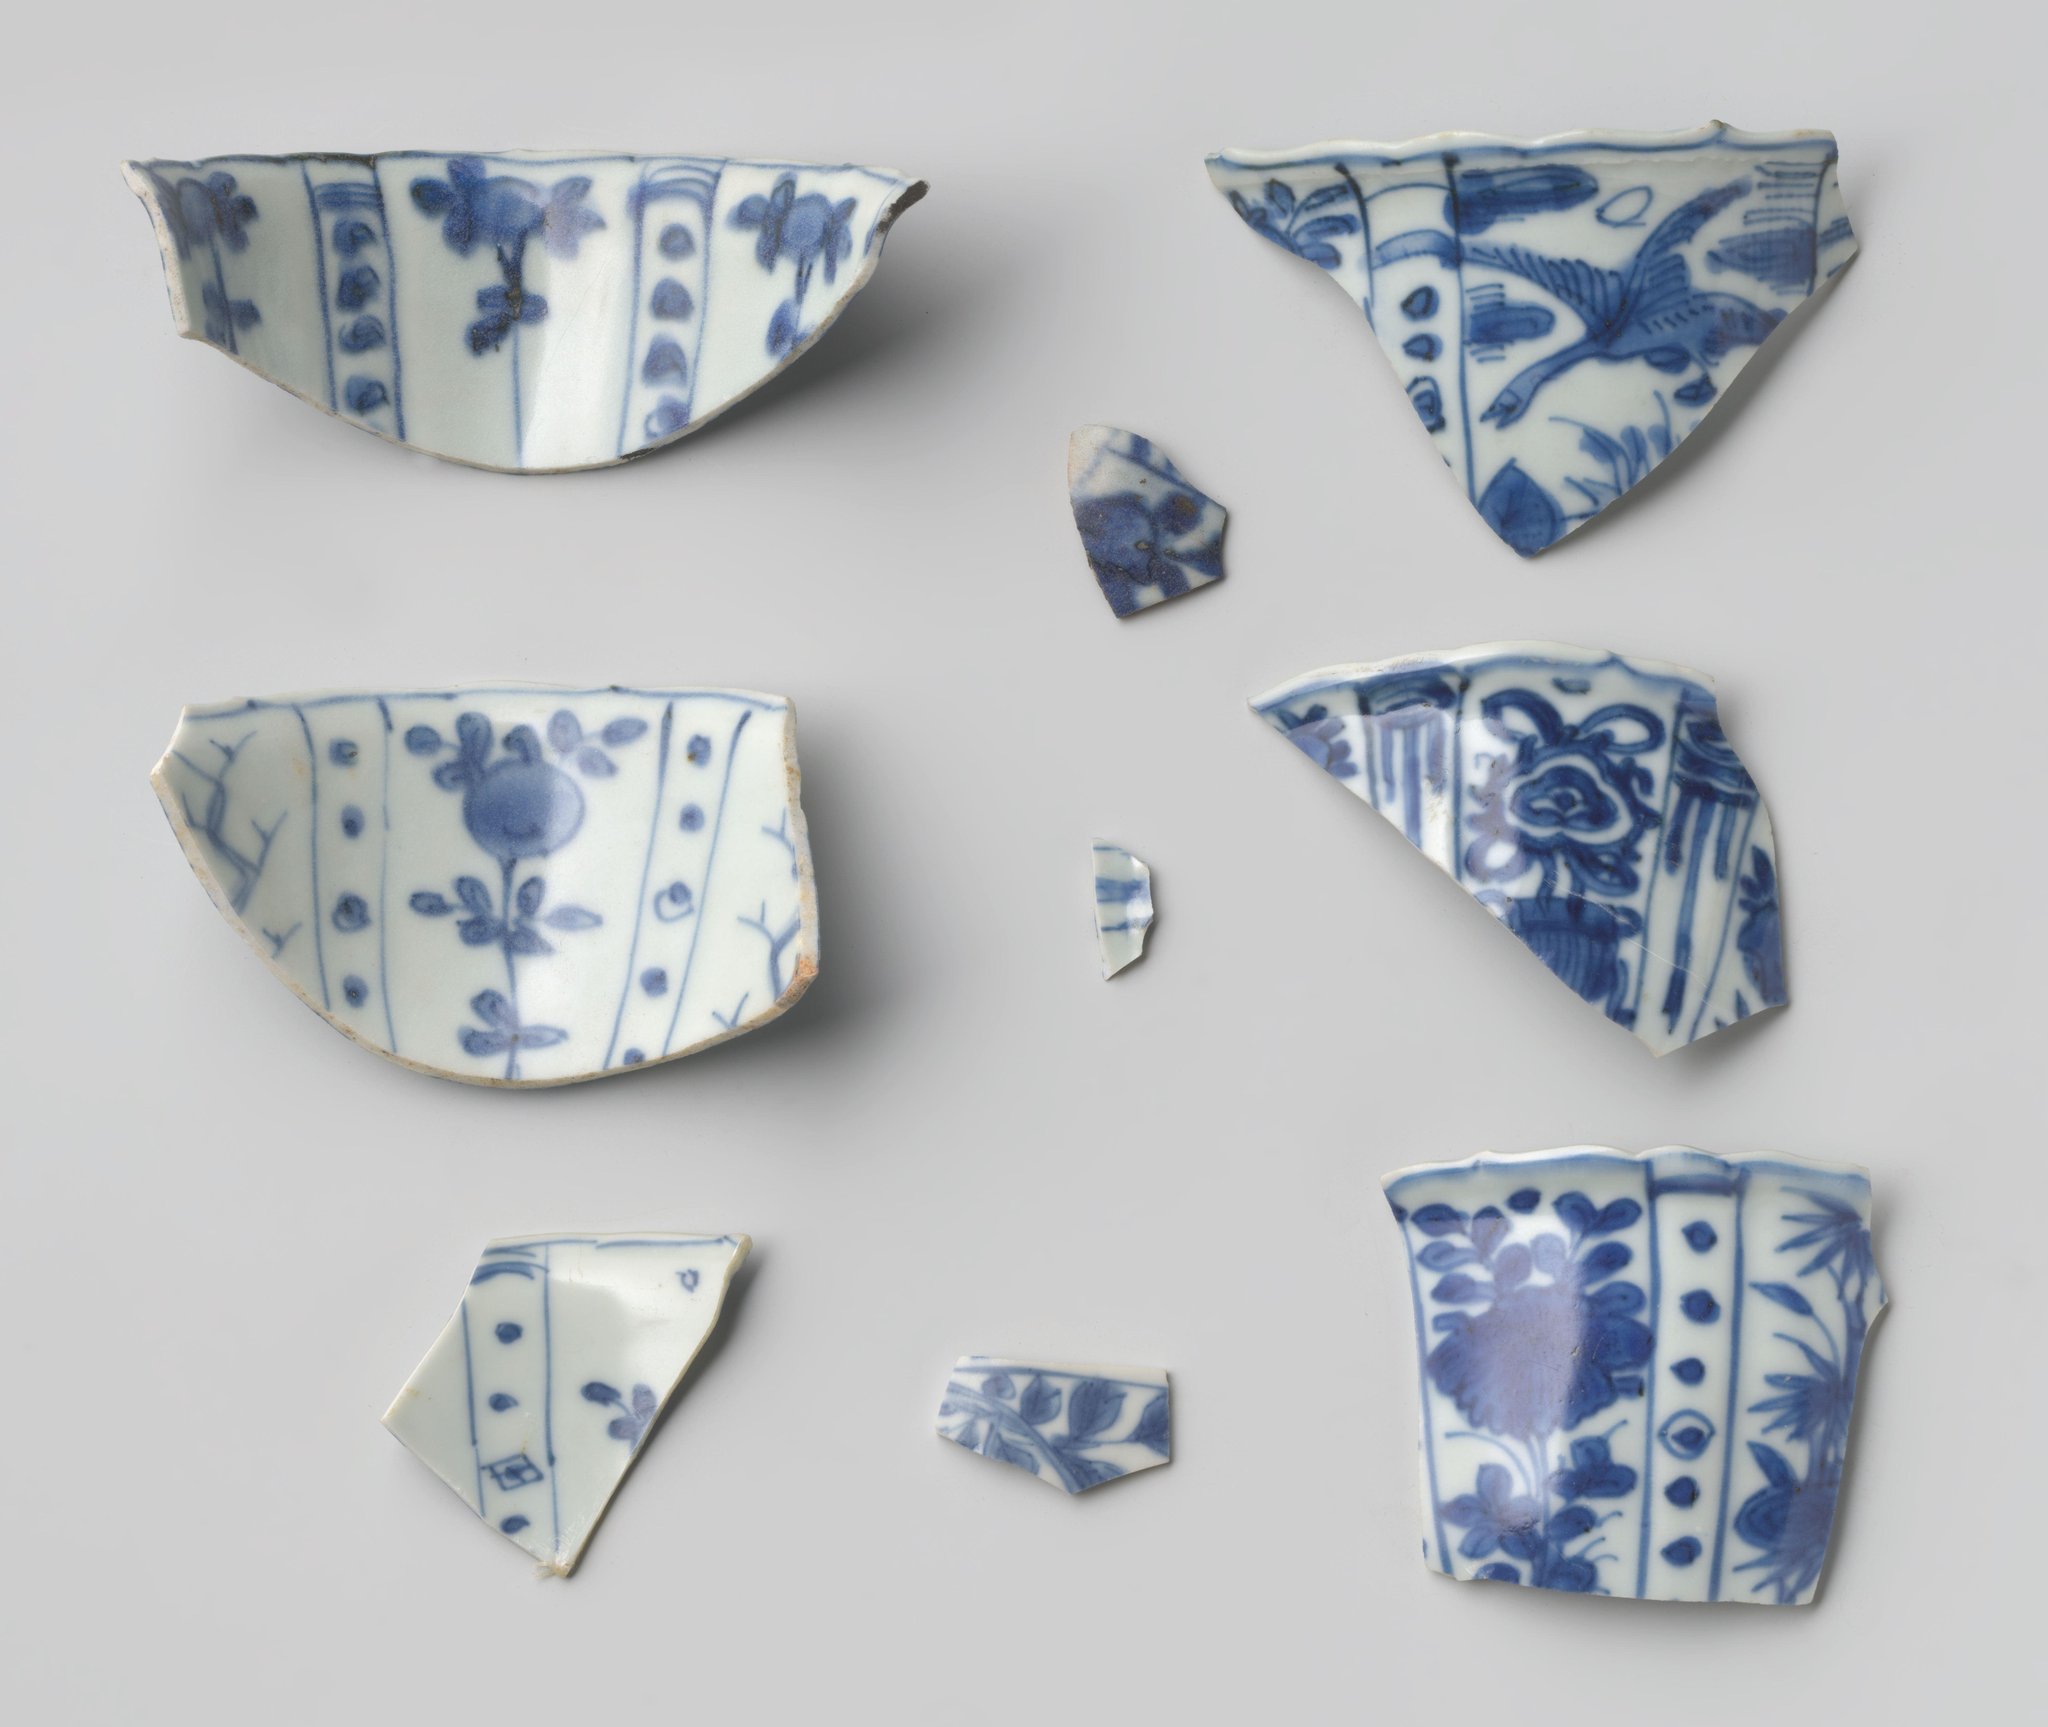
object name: bowl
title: Scherven van kommen uit V.O.C.-schip de 'Witte Leeuw'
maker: Anonymous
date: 1613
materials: bone china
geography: jingdezhen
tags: verenigde oostindische compagnie, sint-helena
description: Scherven kraakporselein uit V.O.C.-schip de 'Witte Leeuw'.